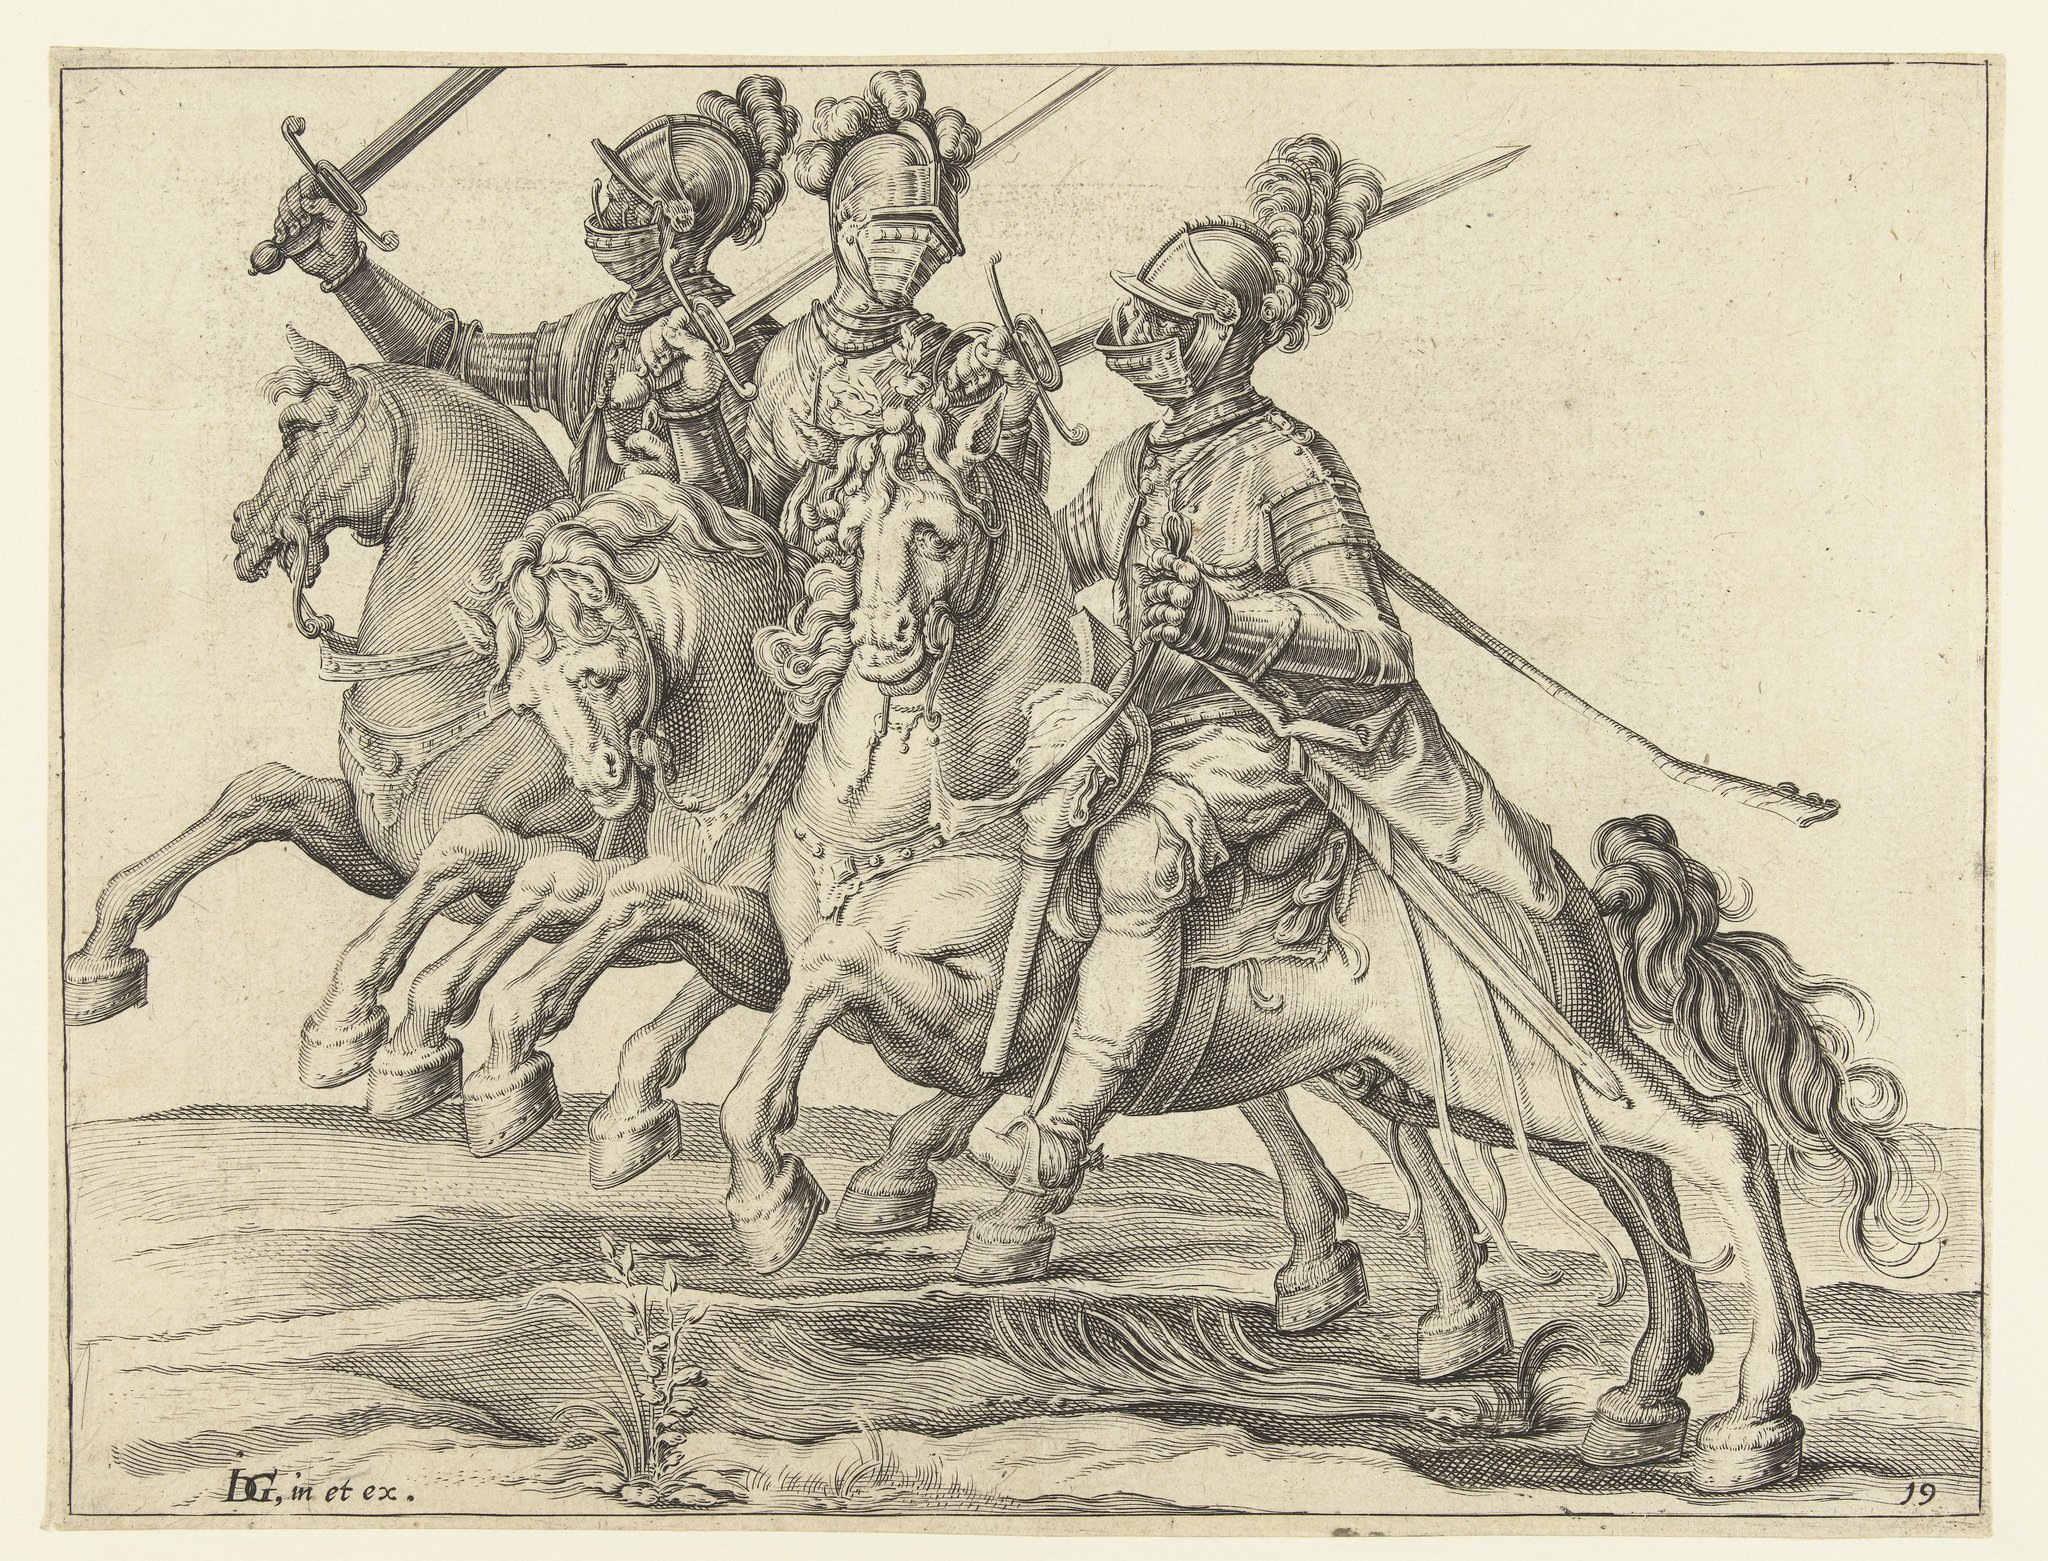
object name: print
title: De ruiterschool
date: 1599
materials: paper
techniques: engraving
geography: leiden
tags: hacking and thrusting weapons: sword, warfare; military affairs (+ cavalry, horsemen)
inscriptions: collector's mark: Lugt 2228a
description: Drie geharnaste mannen te paard, naar links rijdend, elk met een geheven zwaard in de rechterhand. Deze prent is onderdeel van een serie van 22 genummerde prenten: een titelprent, 20 prenten waarop één of enkele verschillende typen (meest geharnaste) ruiters zijn weergegeven, en een prent met een ruitergevecht.